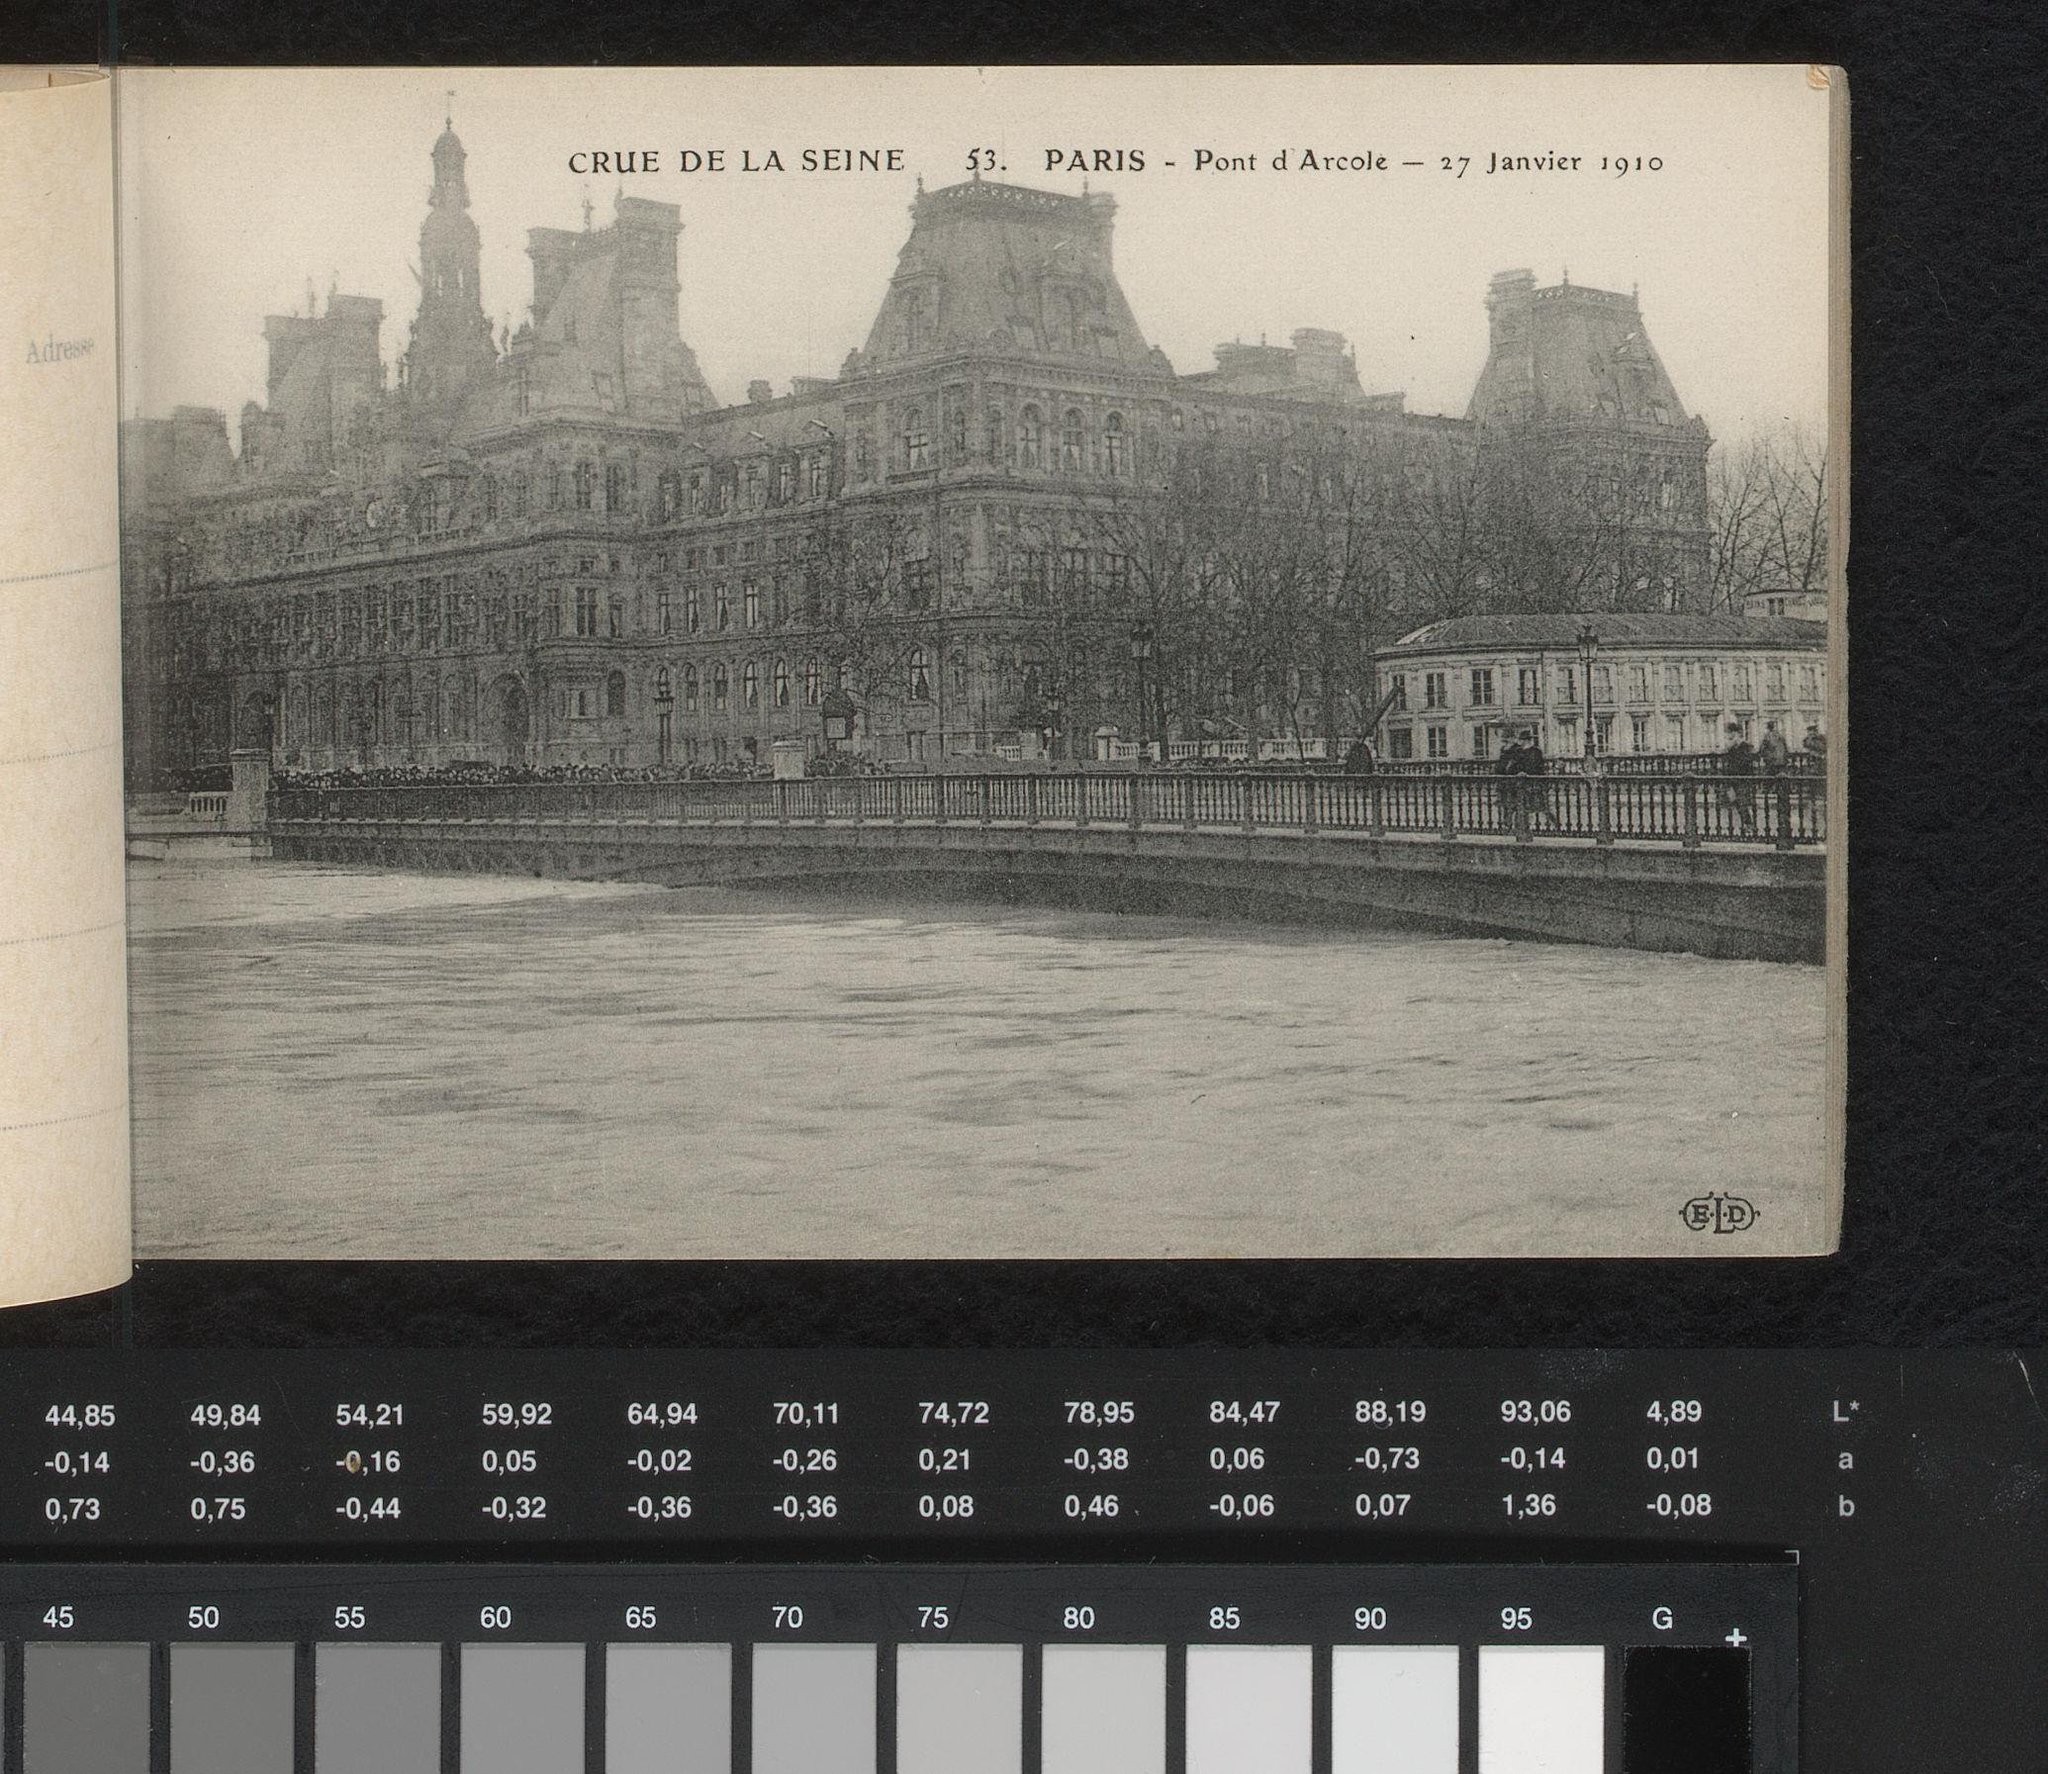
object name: photomechanical print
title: Crue de la Seine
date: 1910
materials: cardboard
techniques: photograph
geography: paris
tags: flood, bridge, city-view, and landscape with man-made constructions (+ city(-scape) with figures, staffage), paris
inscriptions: date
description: Prentbriefkaart maakt deel uit van een album.